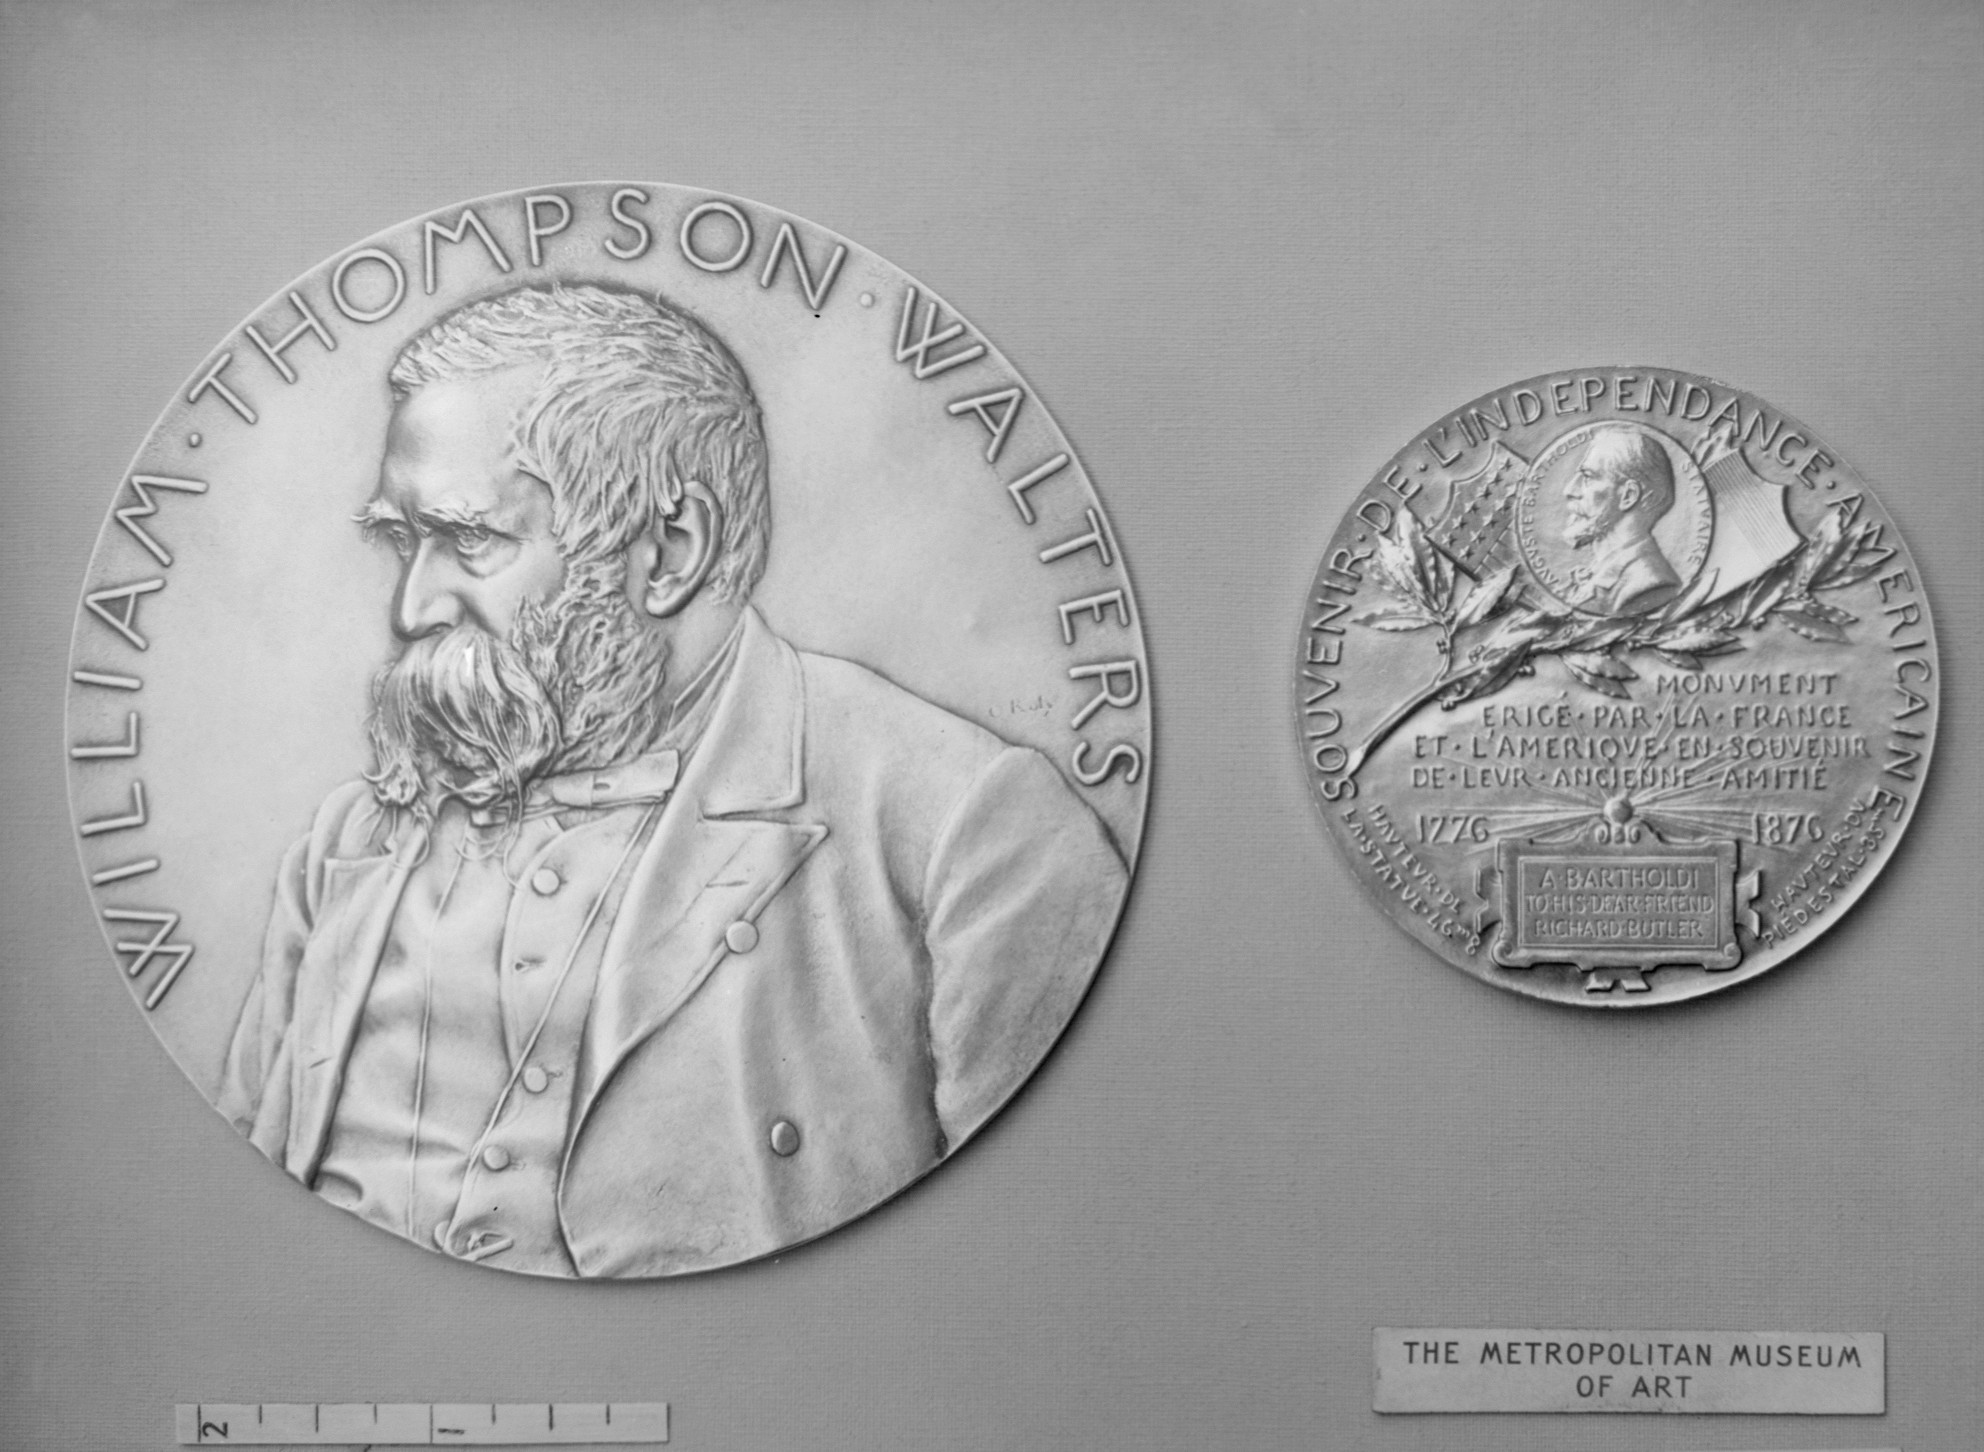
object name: medal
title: The Gift of the Bartholdi Statue of Liberty by the French to the American Republic, 1886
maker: louis-oscar roty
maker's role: artist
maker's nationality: french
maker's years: 1846-1911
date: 1886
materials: bronze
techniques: silvered, struck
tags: men,profiles